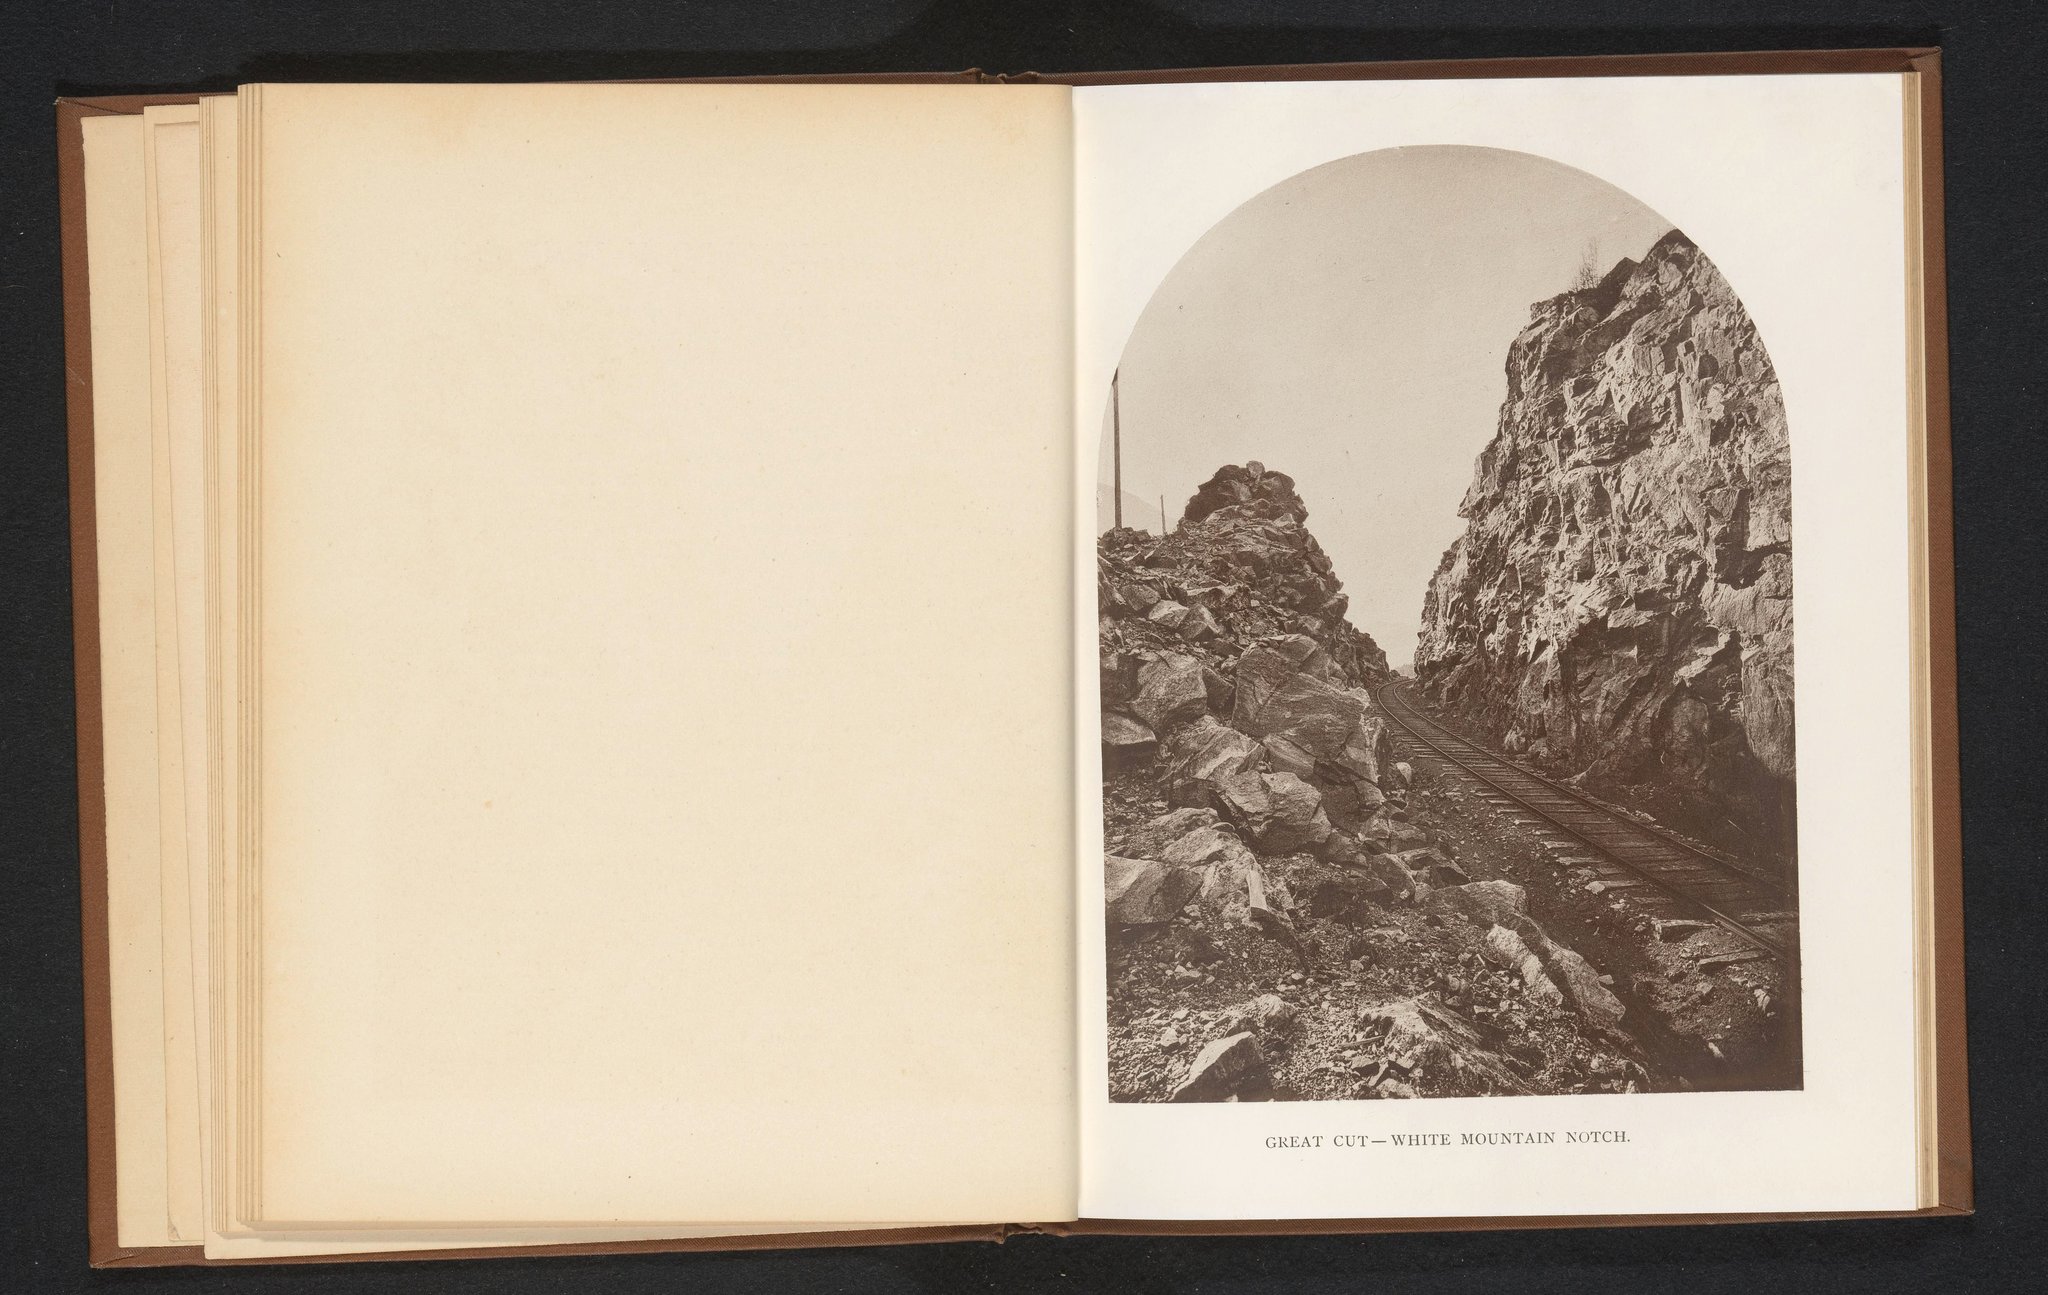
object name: page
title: Great Cut - White Mountain Notch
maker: Anonymous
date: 1874-1879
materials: paper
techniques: photograph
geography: white mountains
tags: railway, train, mountains